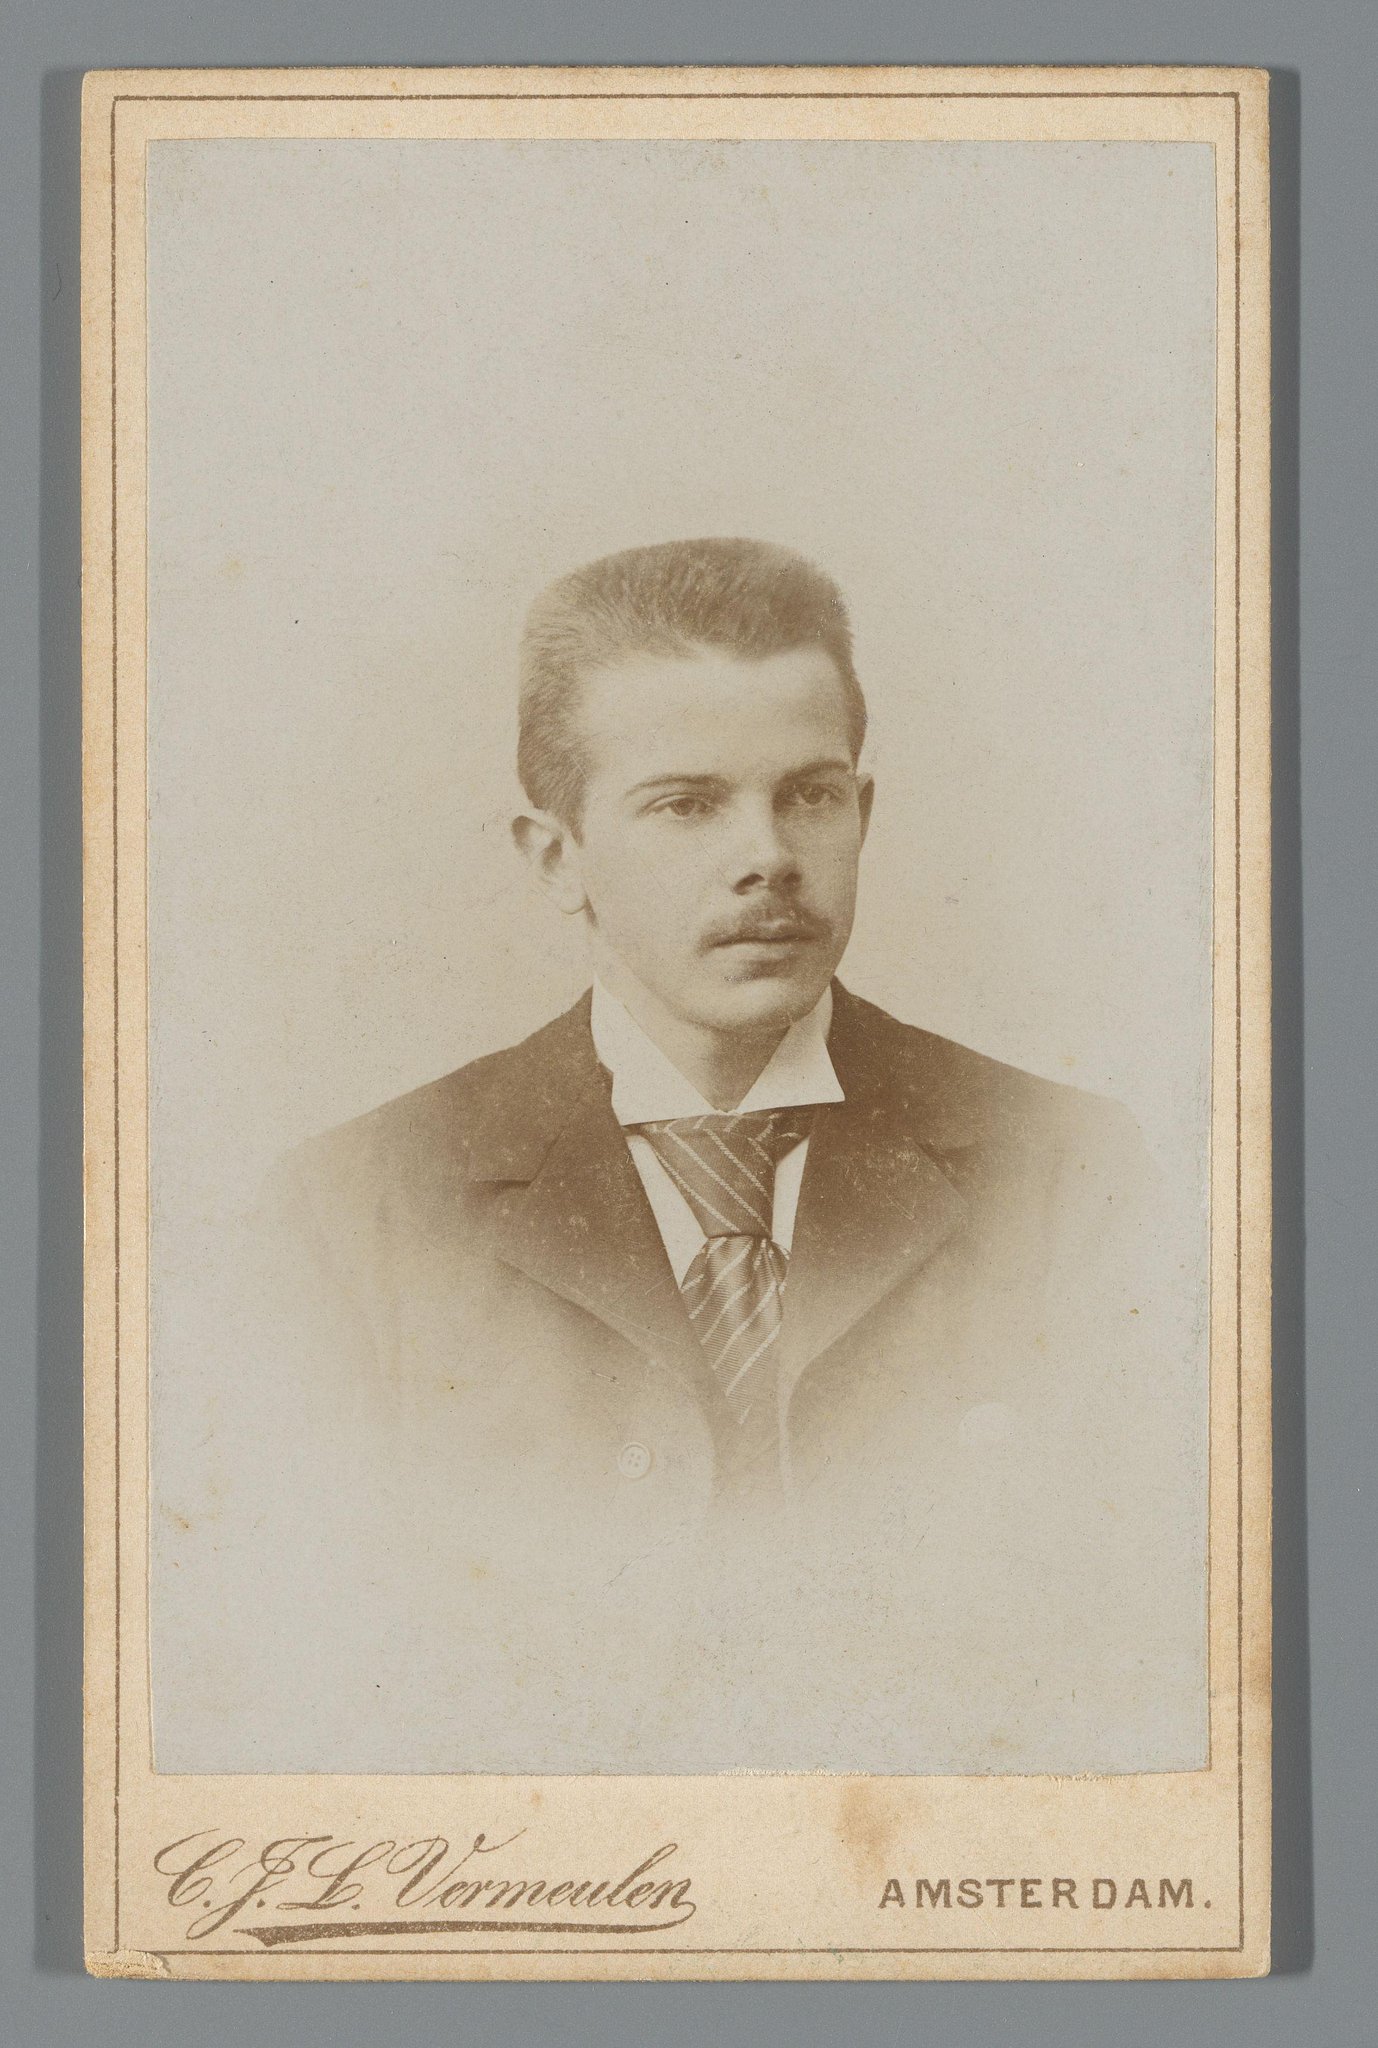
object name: photograph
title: Portret van Hendrik Herman van den Berg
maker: cornelis johannes lodewicus vermeulen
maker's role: fotograaf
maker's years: 1861-1936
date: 1890-1910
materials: cardboard, photographic support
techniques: albumen print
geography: amsterdam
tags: batavia, amsterdam, hendrik herman van den berg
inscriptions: inscription: ‘C.J.L. Vermeulen AMSTERDAM’, inscription: ‘Henk’